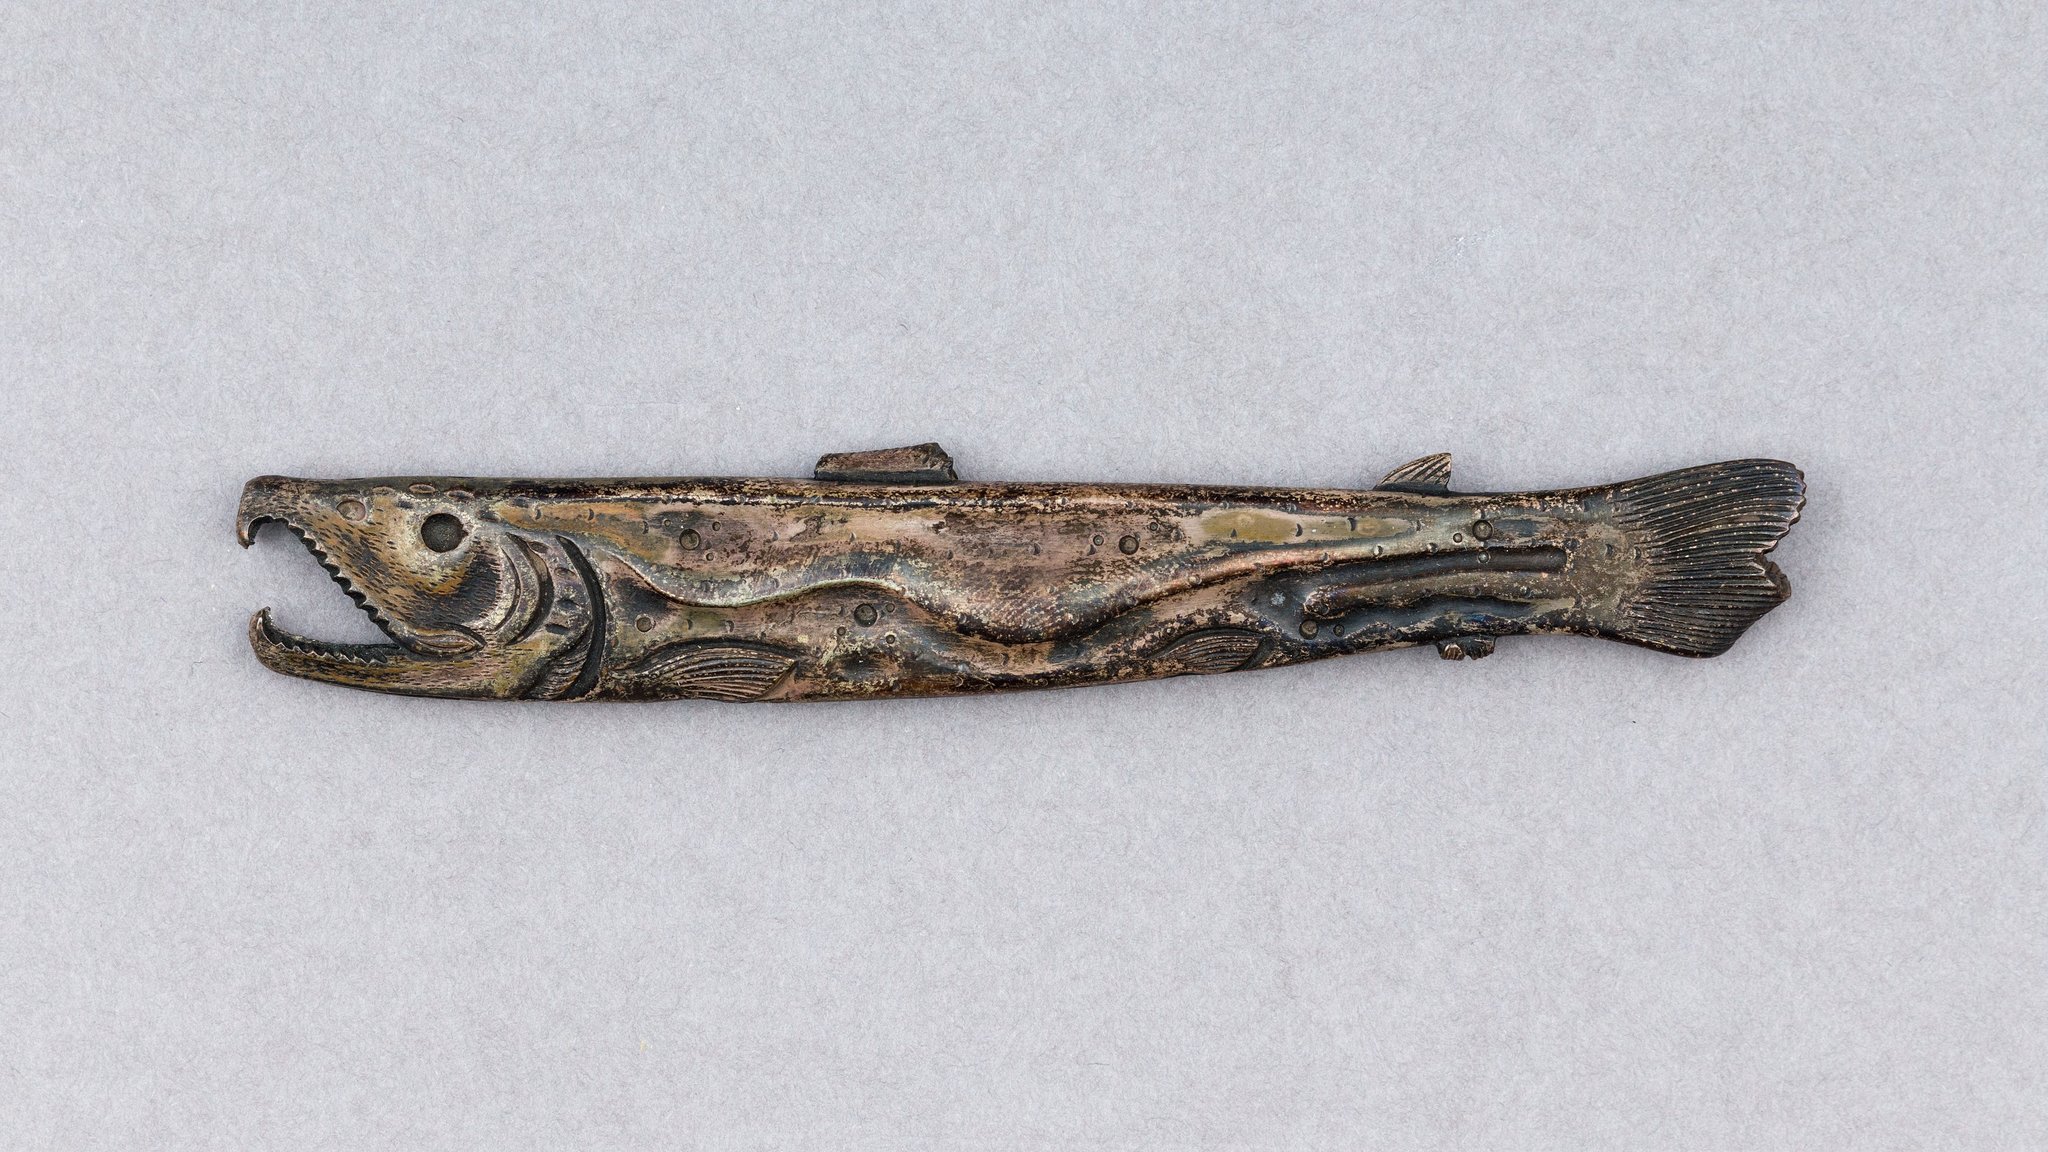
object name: knife handle kozuka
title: Knife Handle (Kozuka)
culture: japanese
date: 1615-1868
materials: silver alloy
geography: japan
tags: fish